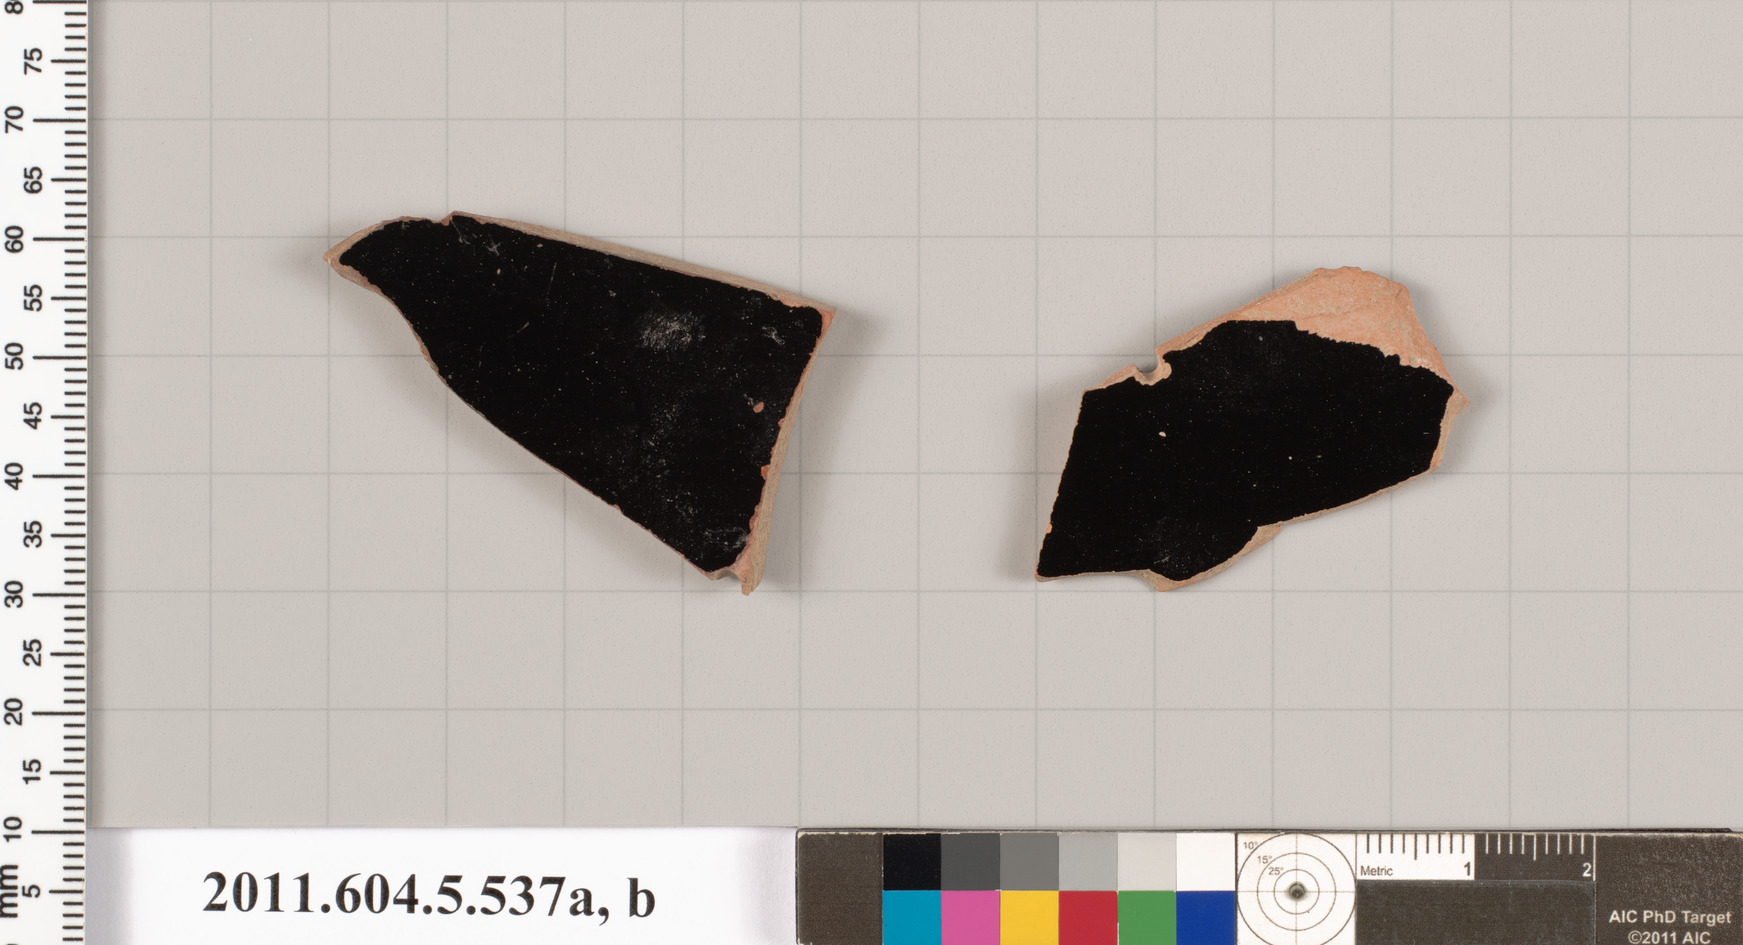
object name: kylix fragment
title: Terracotta fragments of kylikes (drinking cups)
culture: greek, attic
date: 600-401 BCE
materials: terracotta